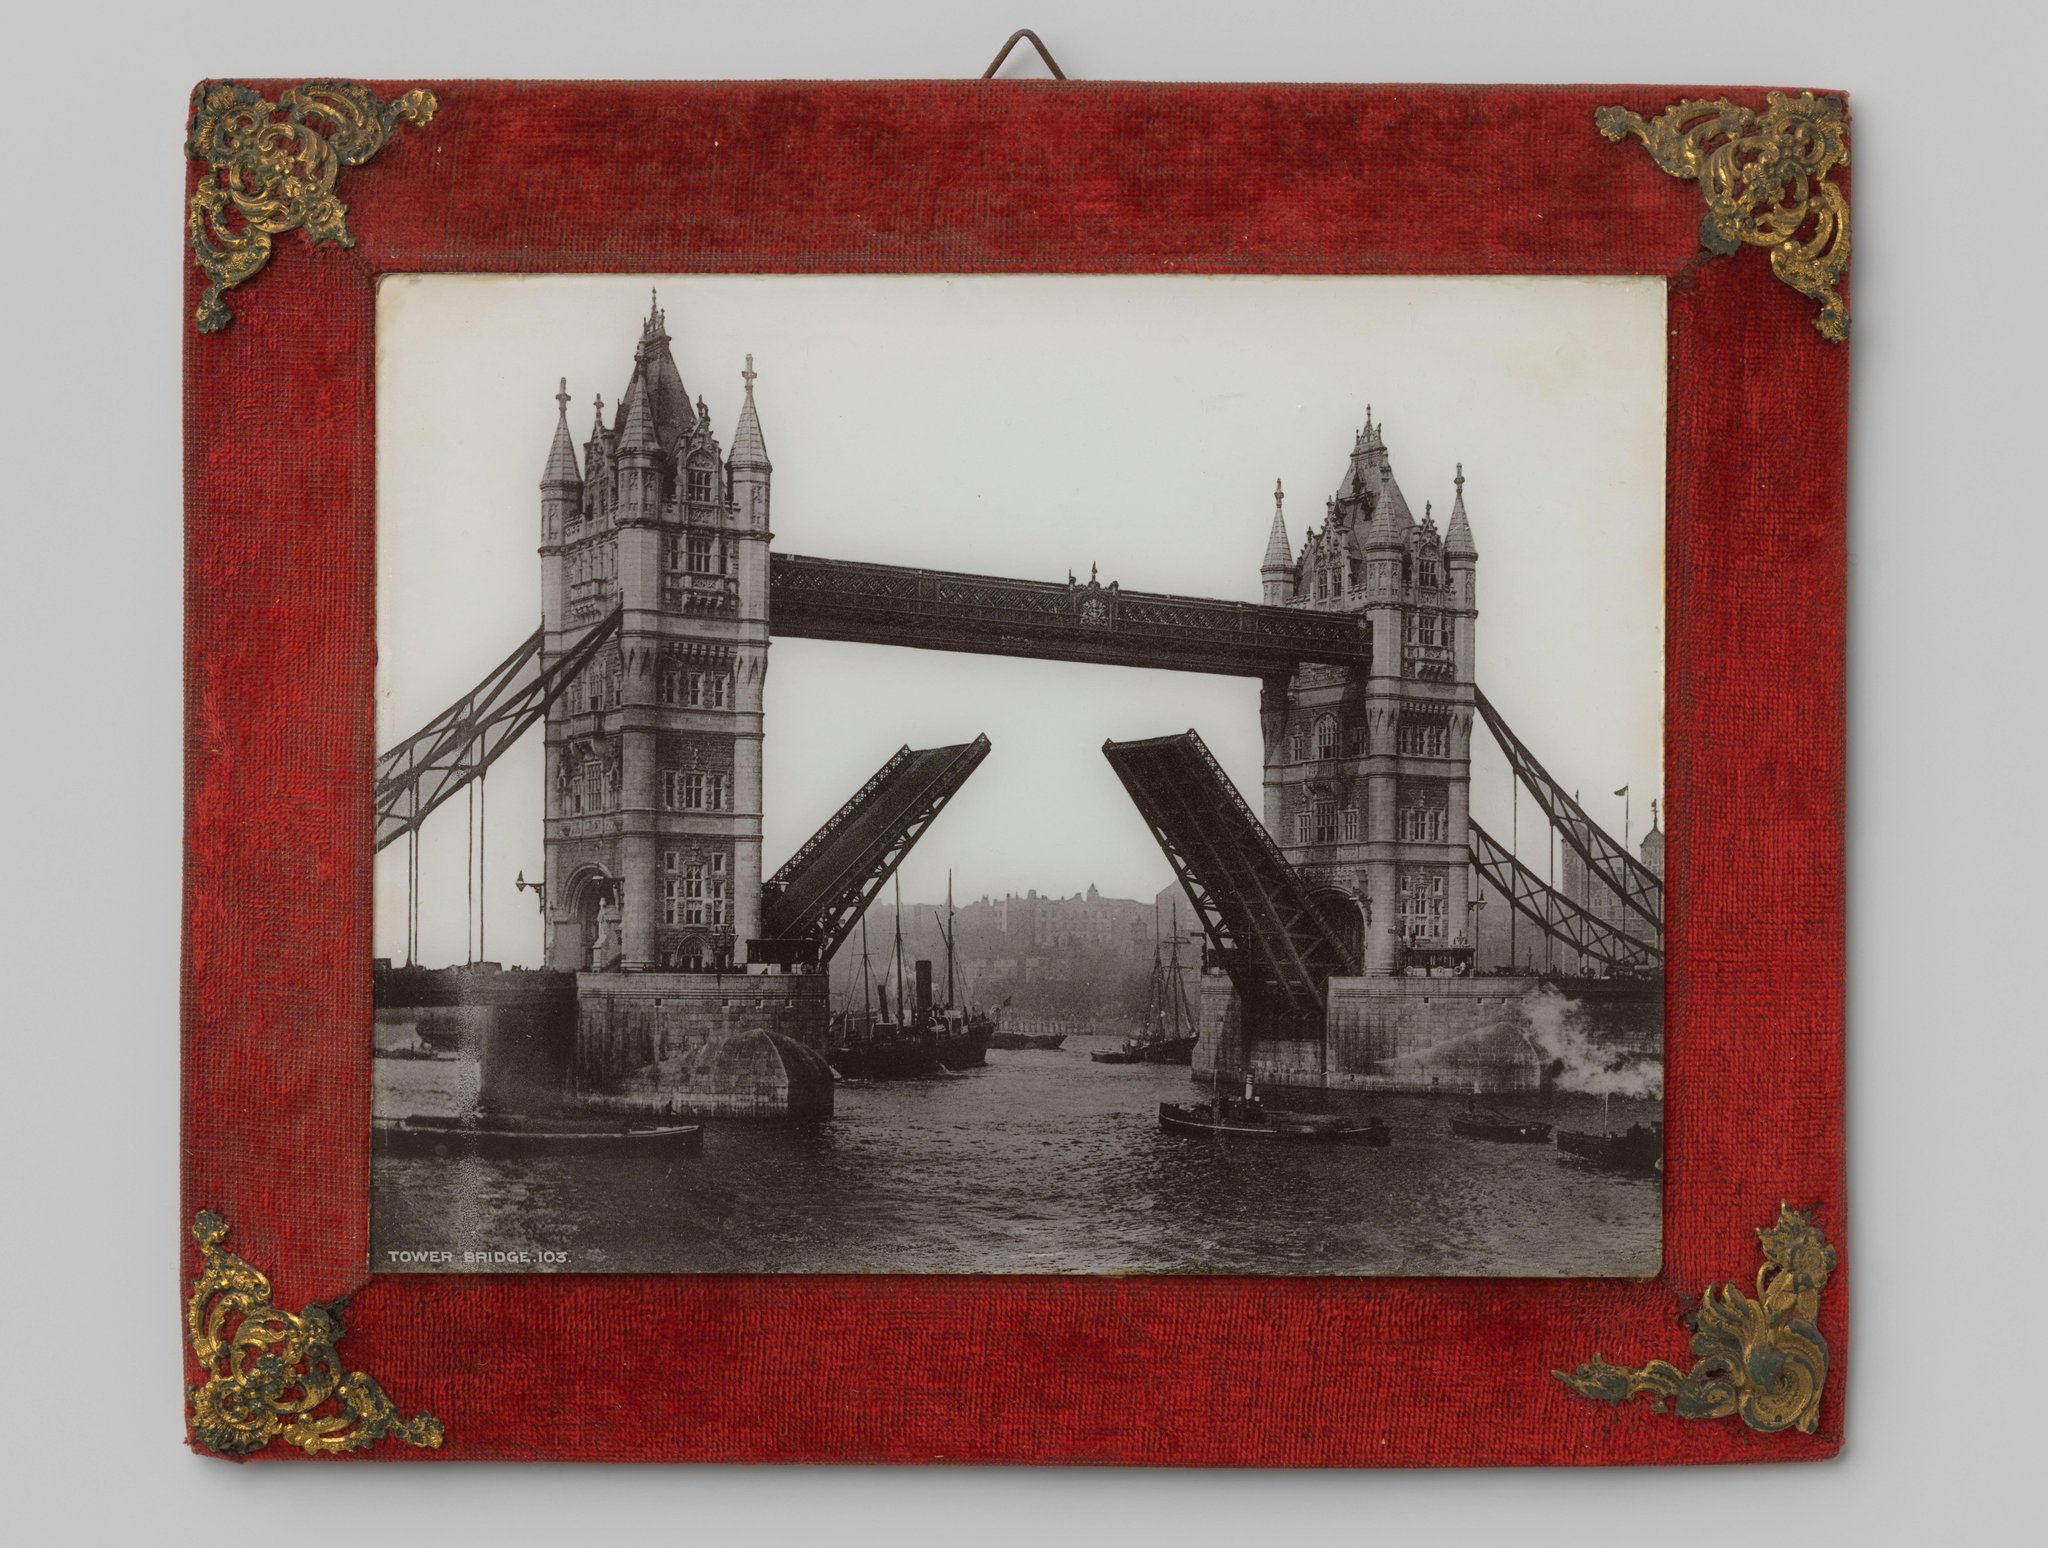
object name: frame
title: Gezicht op de Tower Bridge in Londen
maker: Anonymous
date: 1894-1900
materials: cardboard, glass, metal, paper, velvet, wood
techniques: photograph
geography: london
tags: bridge in city across river, canal, etc.